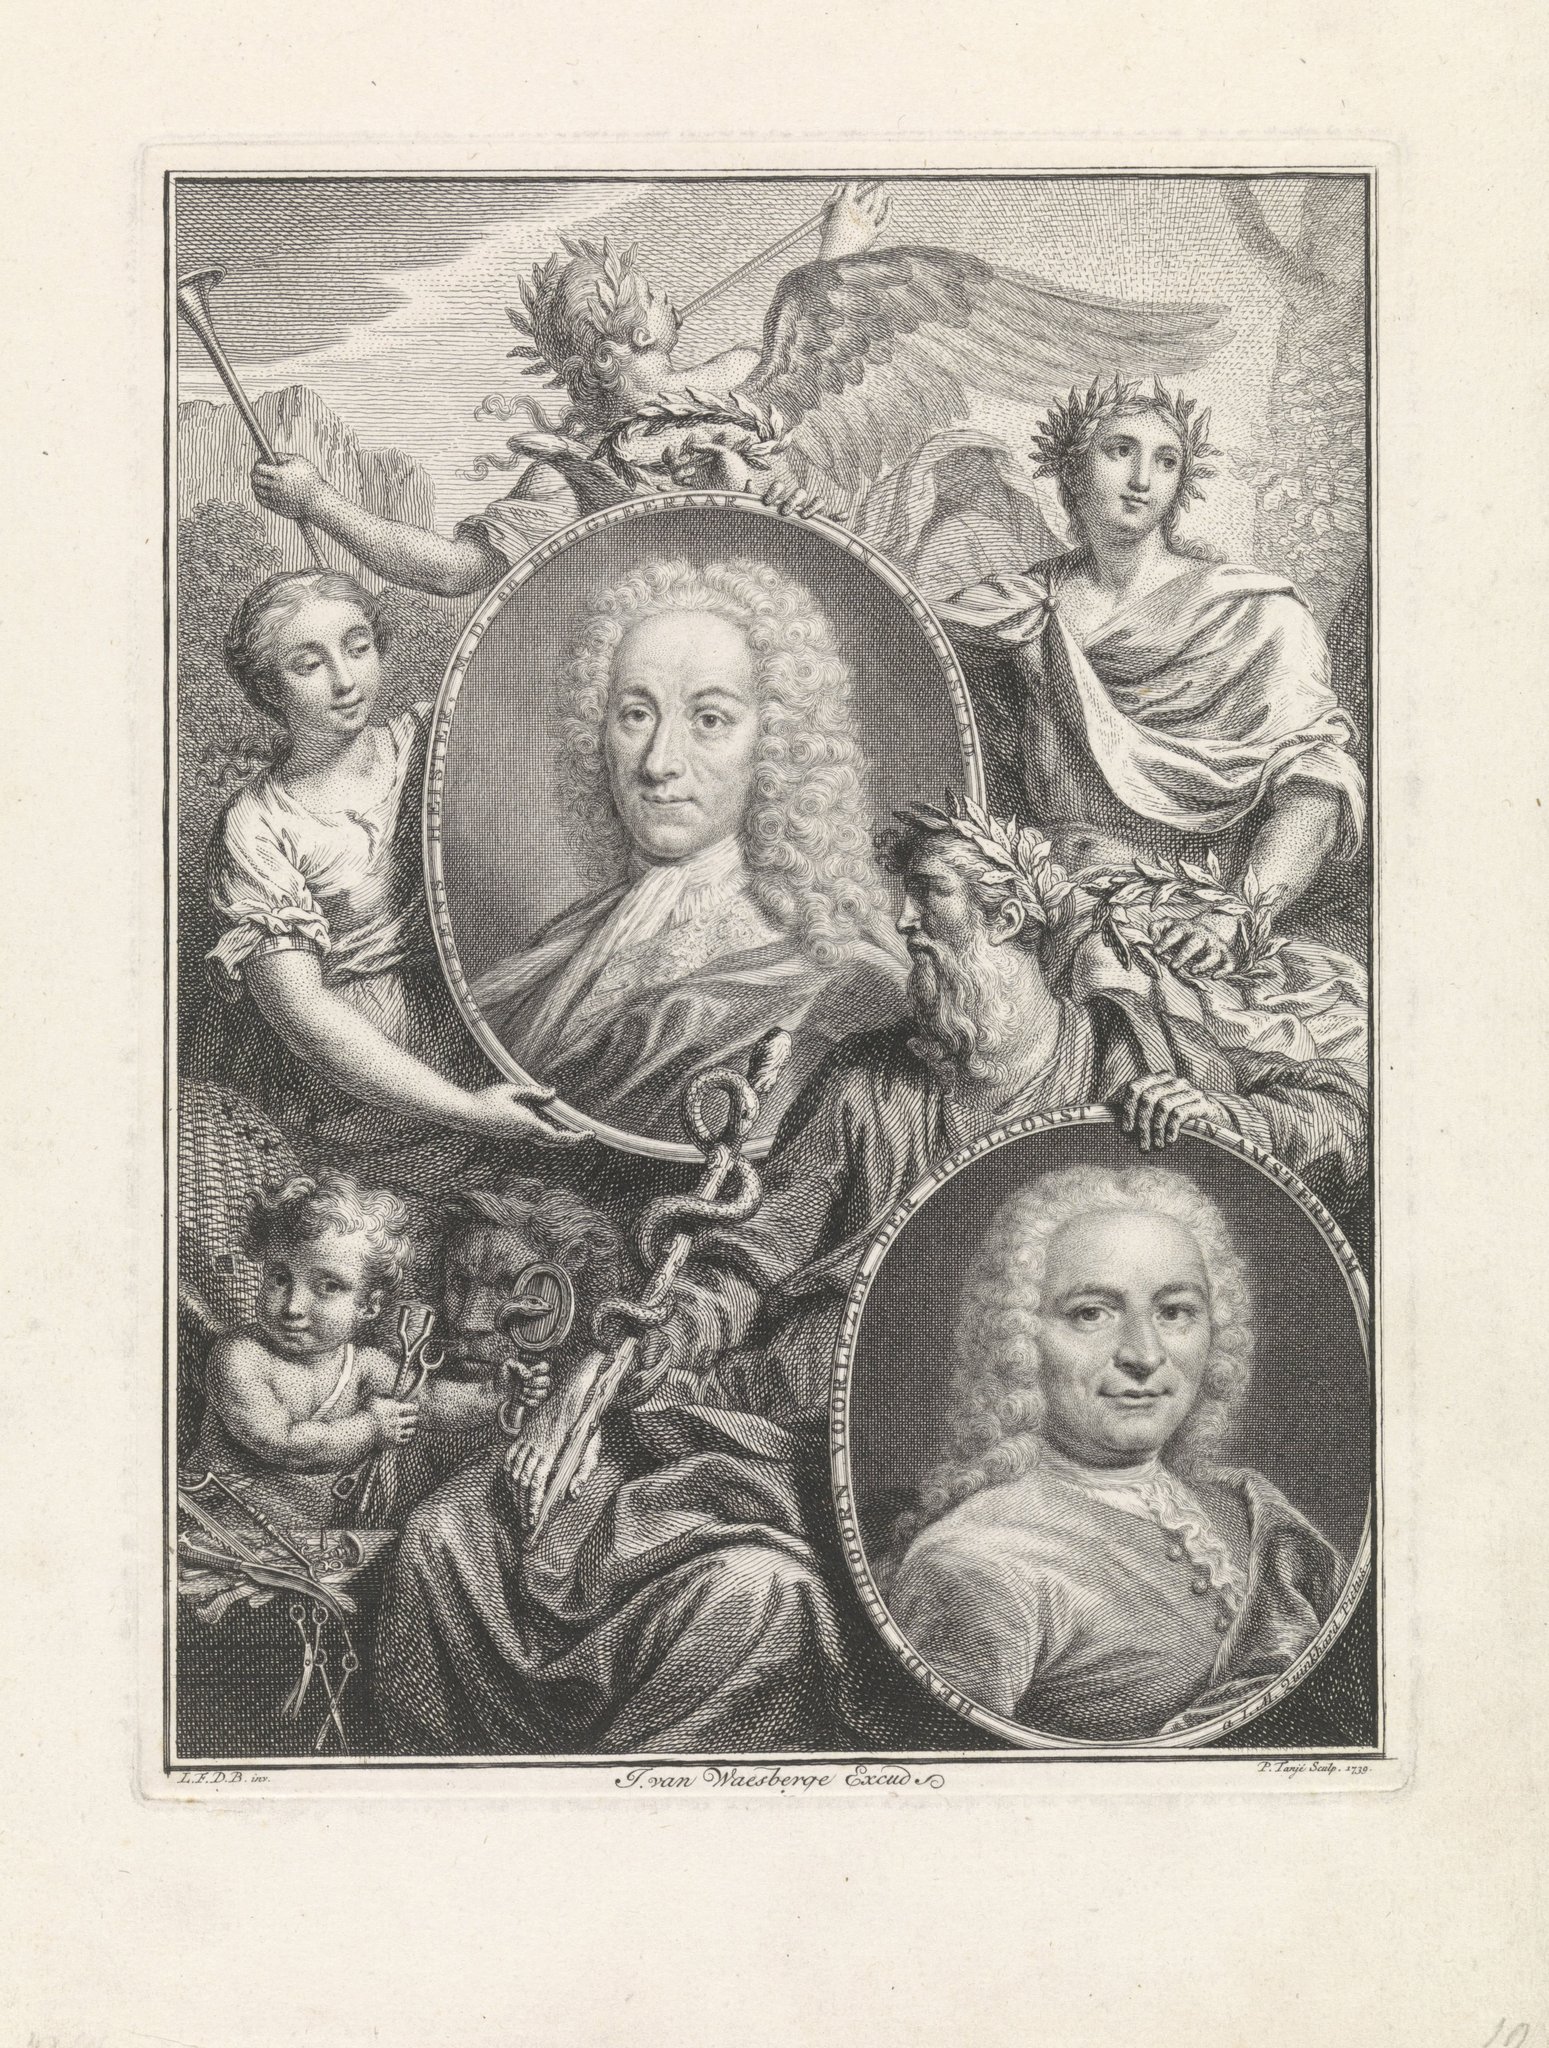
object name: book illustration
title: Portretten van Lorenz Heister en Hendrik Ulhoorn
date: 1739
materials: paper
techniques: engraving, etching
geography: amsterdam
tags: leiden, amsterdam, operation, surgery (+ variant), prudence, 'prudentia'; 'prudenza' (ripa) ~ one of the four cardinal virtues, aesculapian sign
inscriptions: collector's mark: Lugt 240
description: Allegorische figuren met lauwerkransen op het hoofd tonen de portretten van Duits chirurg en hoogleraar Lorenz Heister en de Amsterdamse chirurg Hendrik Ulhoorn. Ulhoorn vertaalde en bewerkte Heisters boek Heelkundige onderwyzingen uit het Duits. Bovenaan blaast Faam op de loftrompet. Aesculapius, de god van de gezondheid en geneeskunst houdt een esculaap in de ene hand en toont met de andere het portret van Ulhoorn. Links een putto met chirurgische instrumenten en een spiegel met slang, als symbool van de Voorzichtigheid.